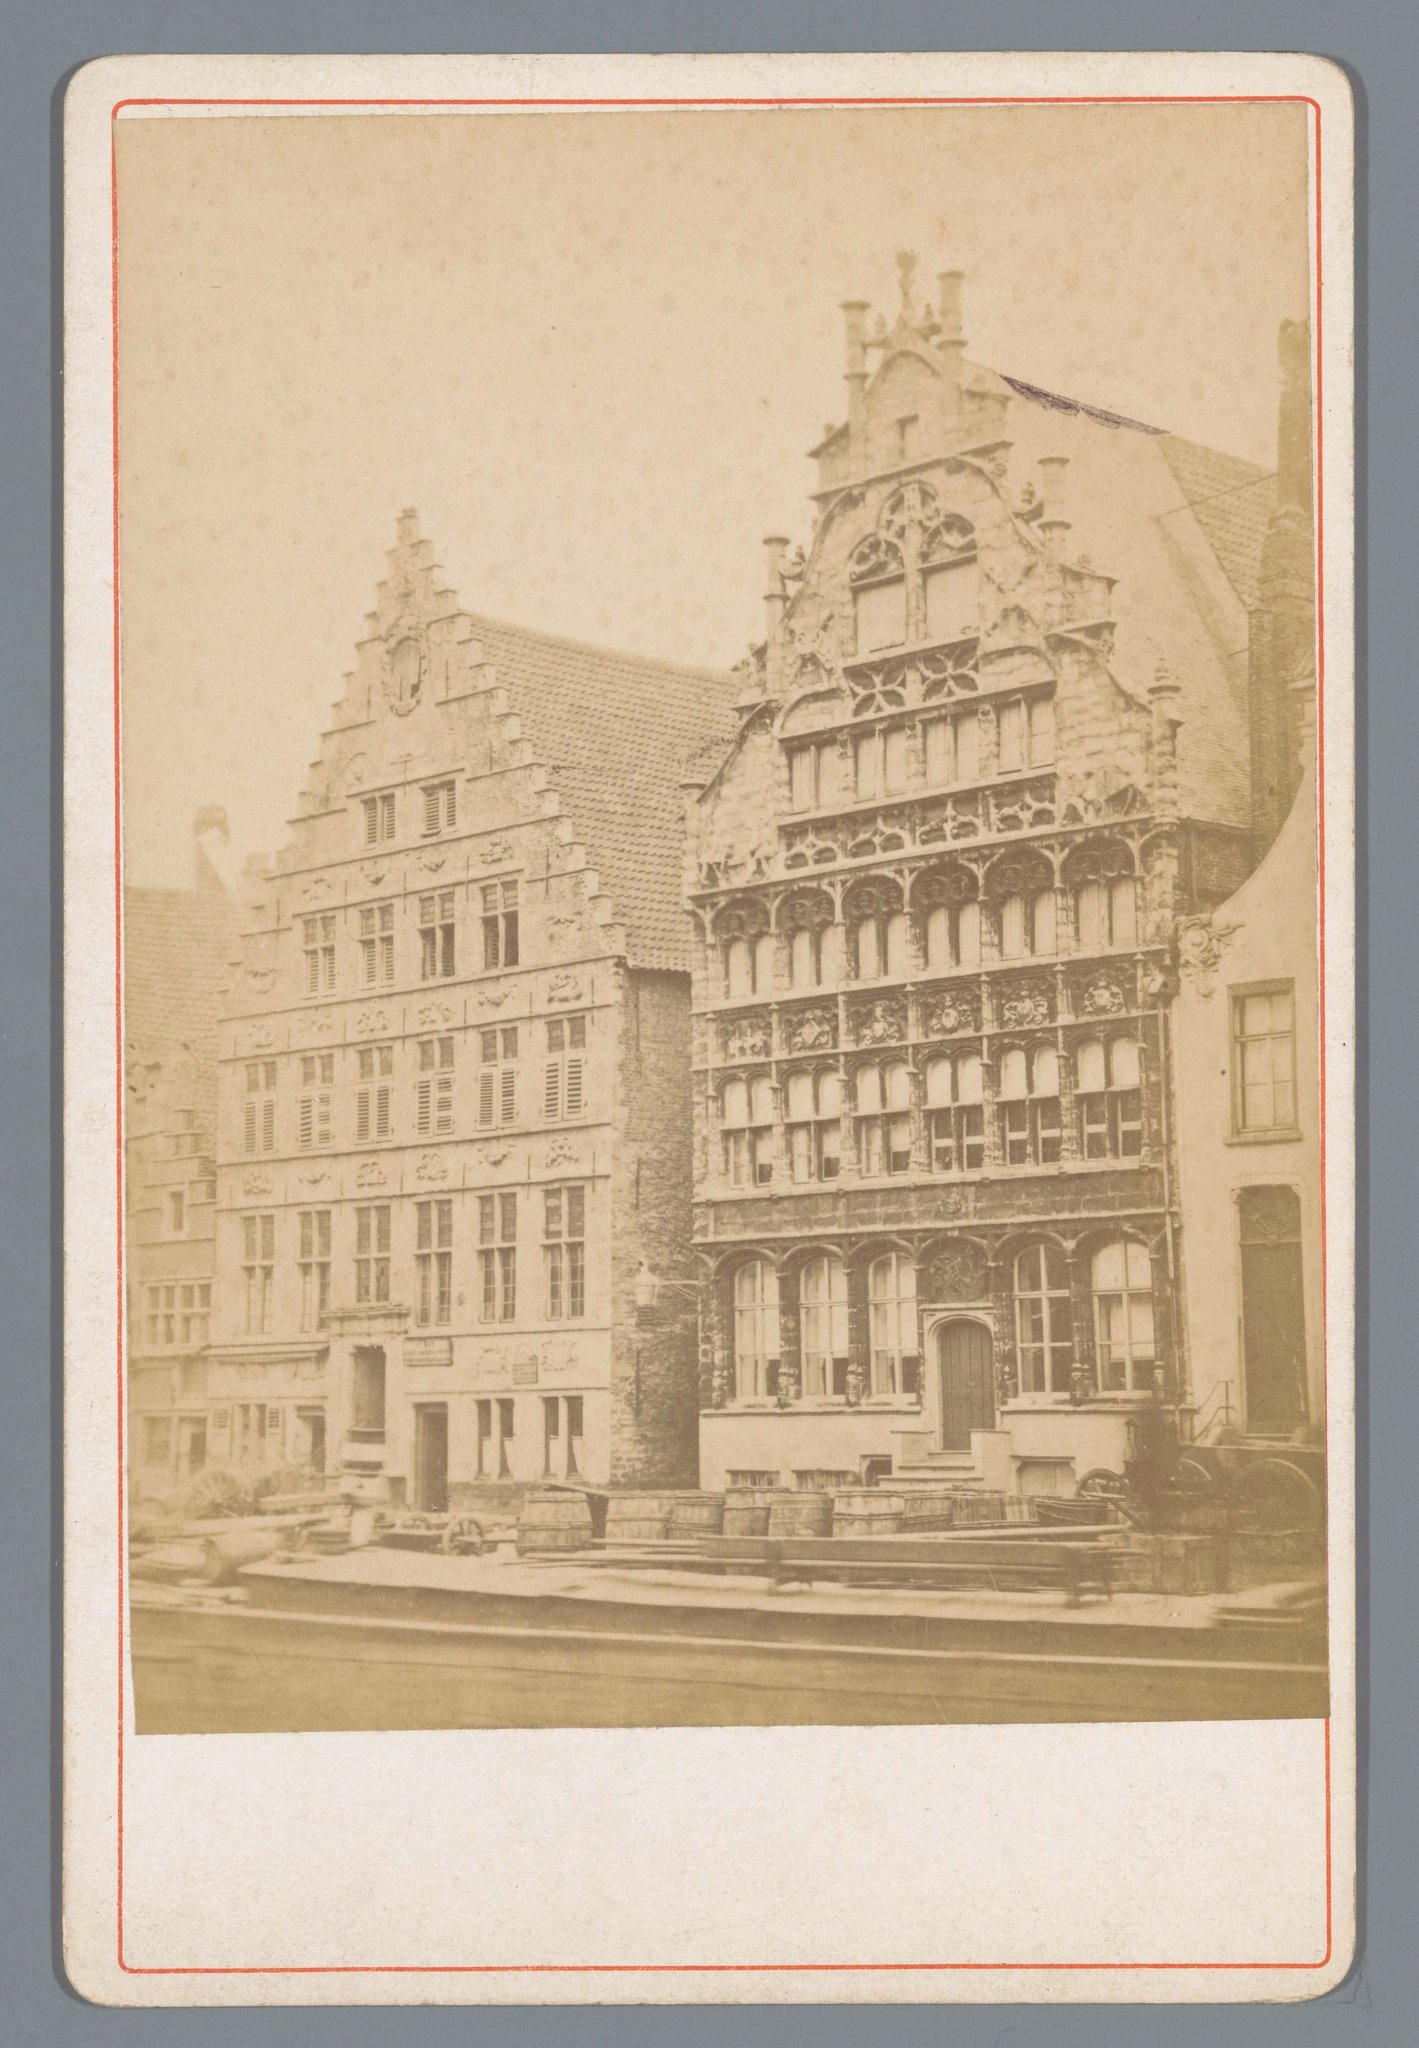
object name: cabinet photograph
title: Gezicht op het Gildehuis van Vrije Schippers in Gent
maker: Anonymous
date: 1850-1900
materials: cardboard, photographic support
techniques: albumen print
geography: gildehuis der vrije schippers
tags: warehouse (~ harbour)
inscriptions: annotation: ‘Gent graslei’